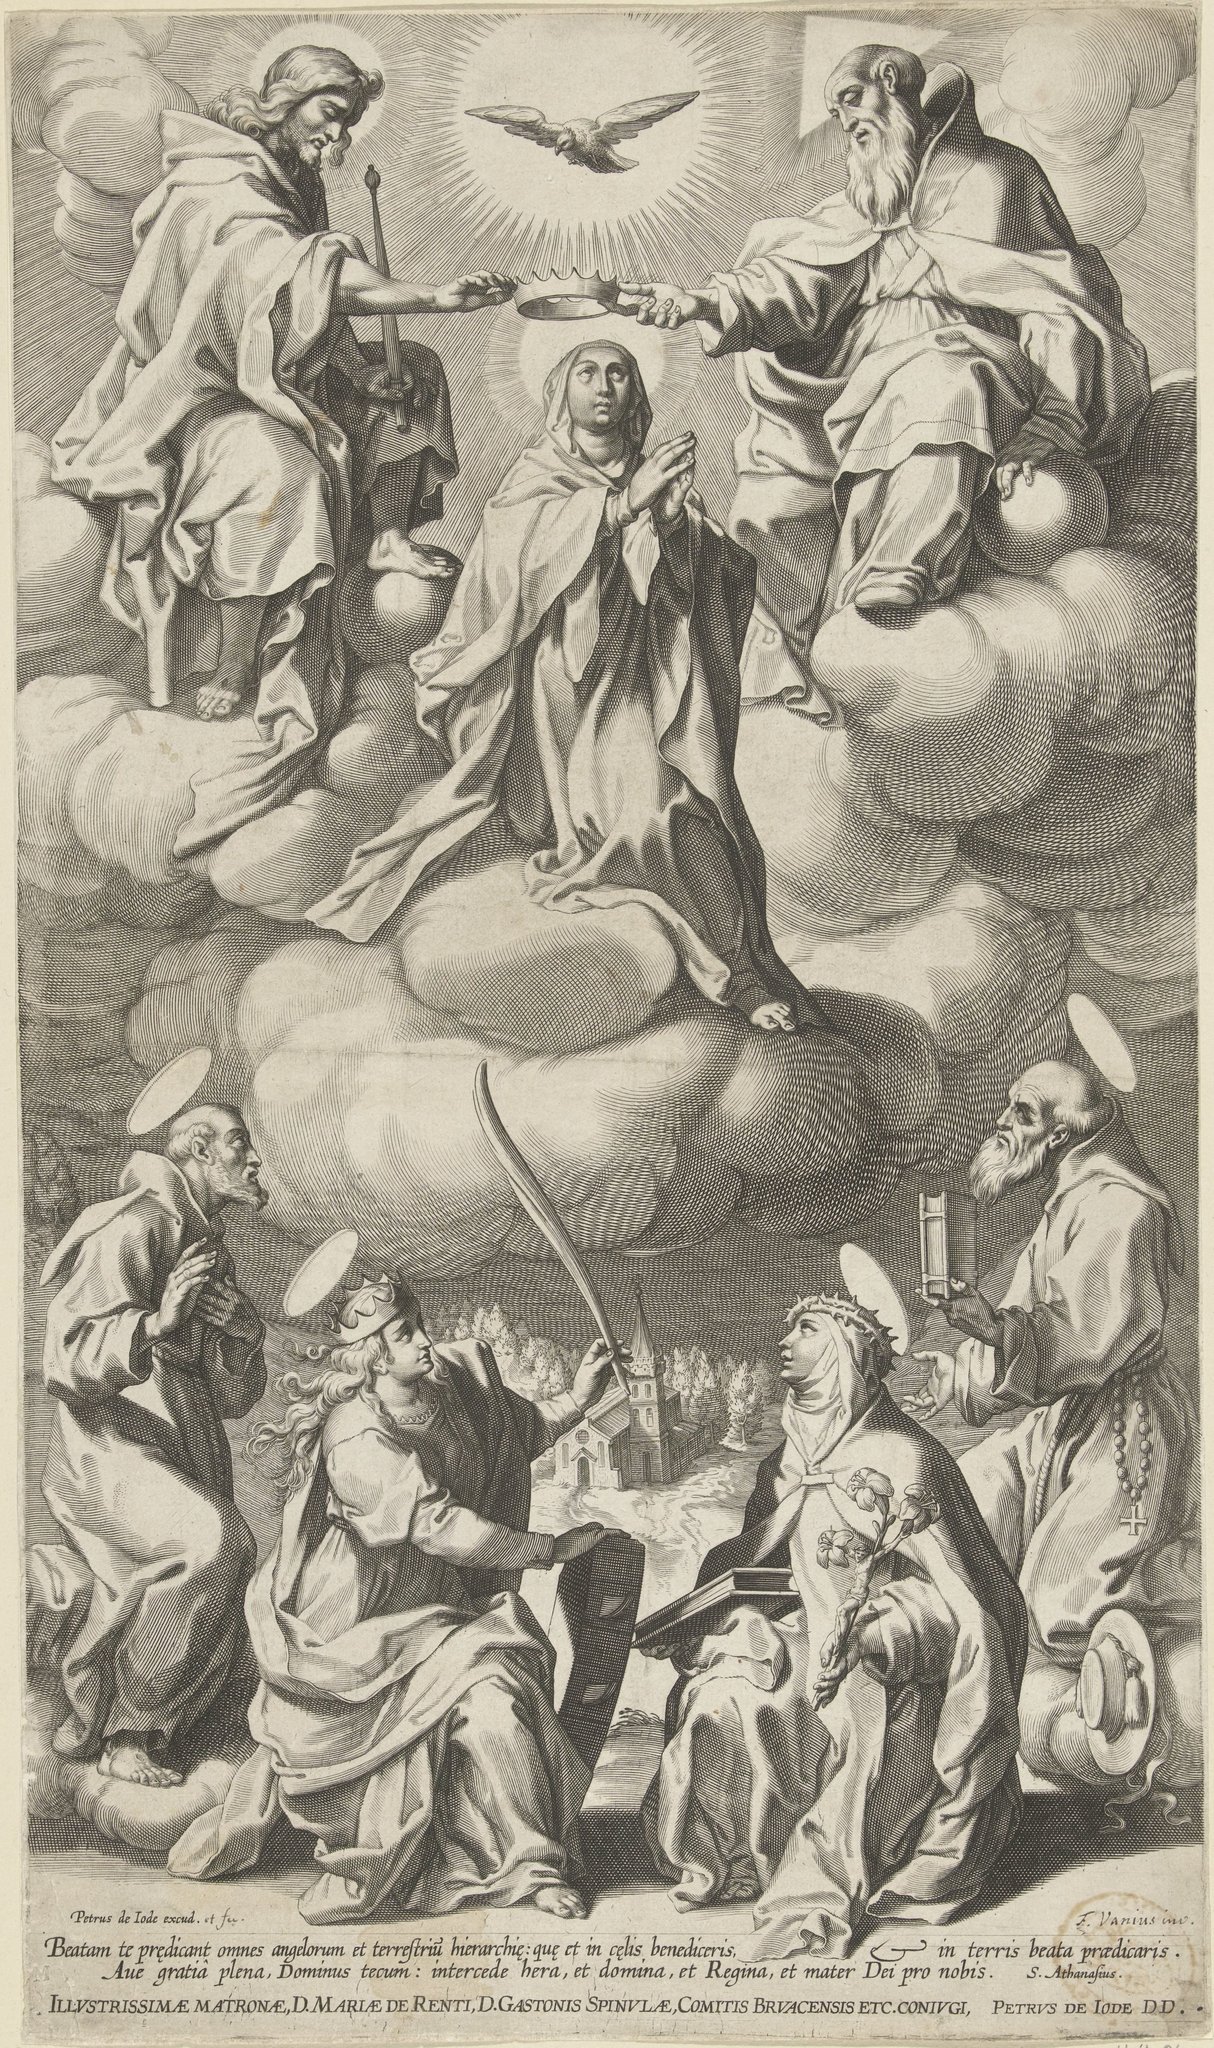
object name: print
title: Kroning van Maria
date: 1590-1632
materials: paper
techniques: engraving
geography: italy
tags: the virgin and dominican tertiary, catherine of siena; possible attributes: book, cross, crown of thorns, crucifix, demon under foot, heart (with cross), lily, plague-stricken, ring, rosary, stigmata, coronation of mary by god the father and christ, the virgin martyr catherine of alexandria; possible attributes: book, crown, emperor maxentius, palm-branch, ring, sword, wheel - female saint as patroness, protectress, intercessor, the monk and hermit jerome (hieronymus); possible attributes: book, cardinal's hat, crucifix, hour-glass, lion, skull, stone - male saint represented in a group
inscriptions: collector's mark: Lugt 240, inscription: ‘et fec.’, inscription: ‘F. Vanius inv.’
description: De maagd Maria wordt in de hemel door God en Christus gekroond. Boven haar de Heilige Geest (als duif). Onder hen, op aarde, vier heiligen in aanbidding. Van links naar rechts: een mannelijke heilige, de H. Catharina, de H. Catharina van Siena en de H. Hieronymus. In de marge een onderschrift in het Latijn.